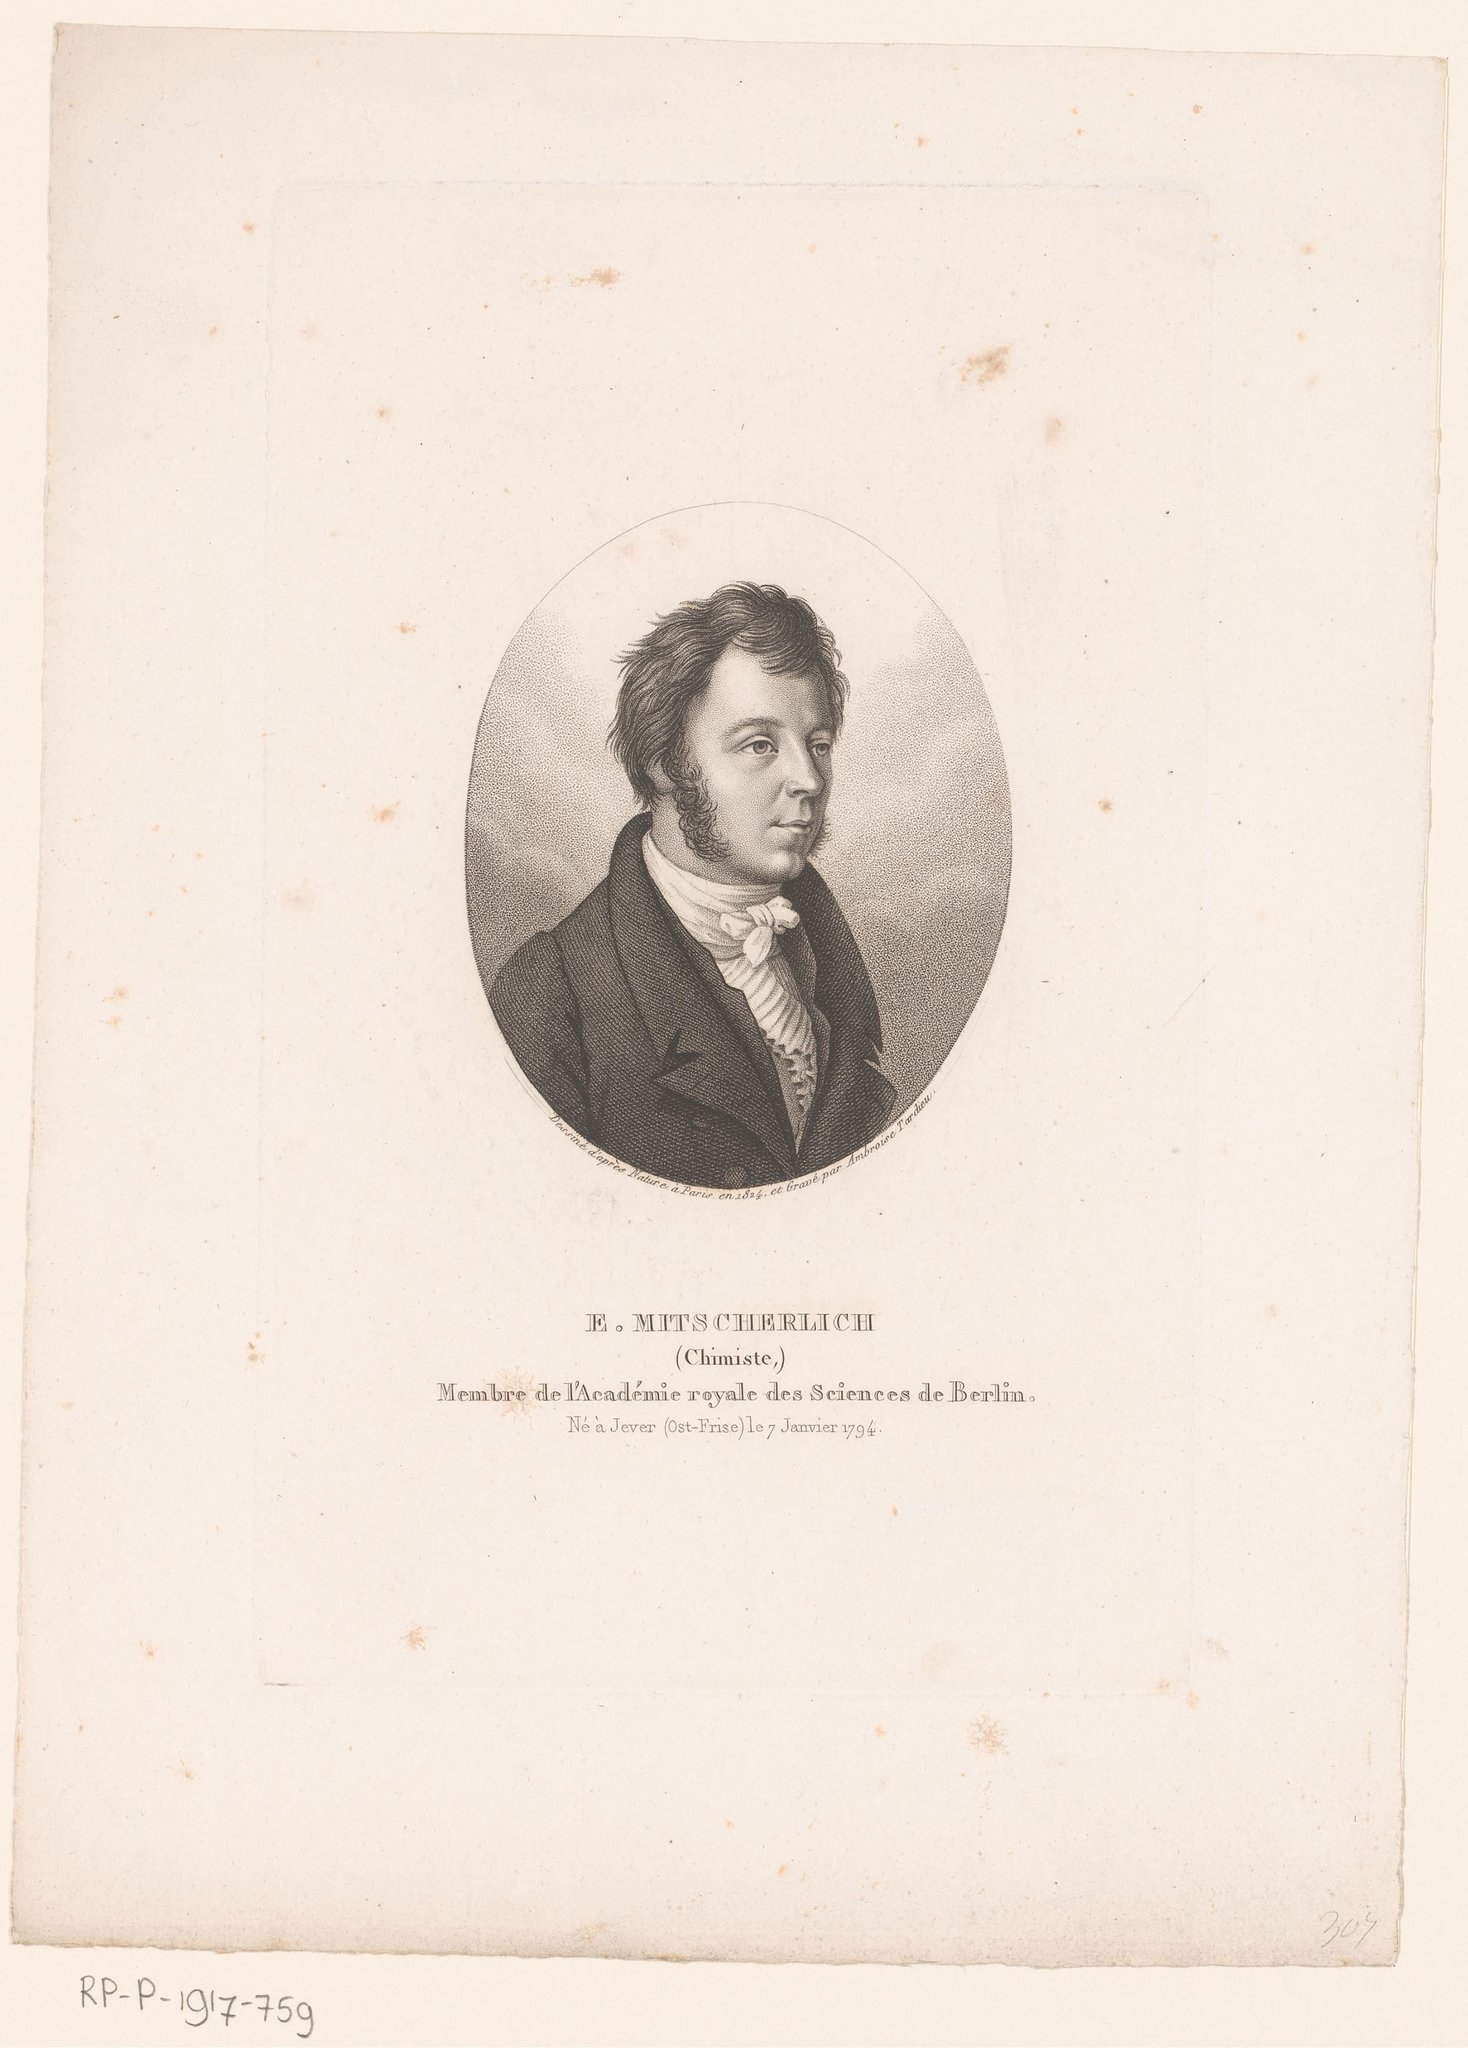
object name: print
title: Compleet overzicht van beroemdheden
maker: ambroise tardieu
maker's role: print maker, printer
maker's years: 1788-1841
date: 1824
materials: paper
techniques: engraving, roulette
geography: paris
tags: historical persons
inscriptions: collector's mark: Lugt 2228